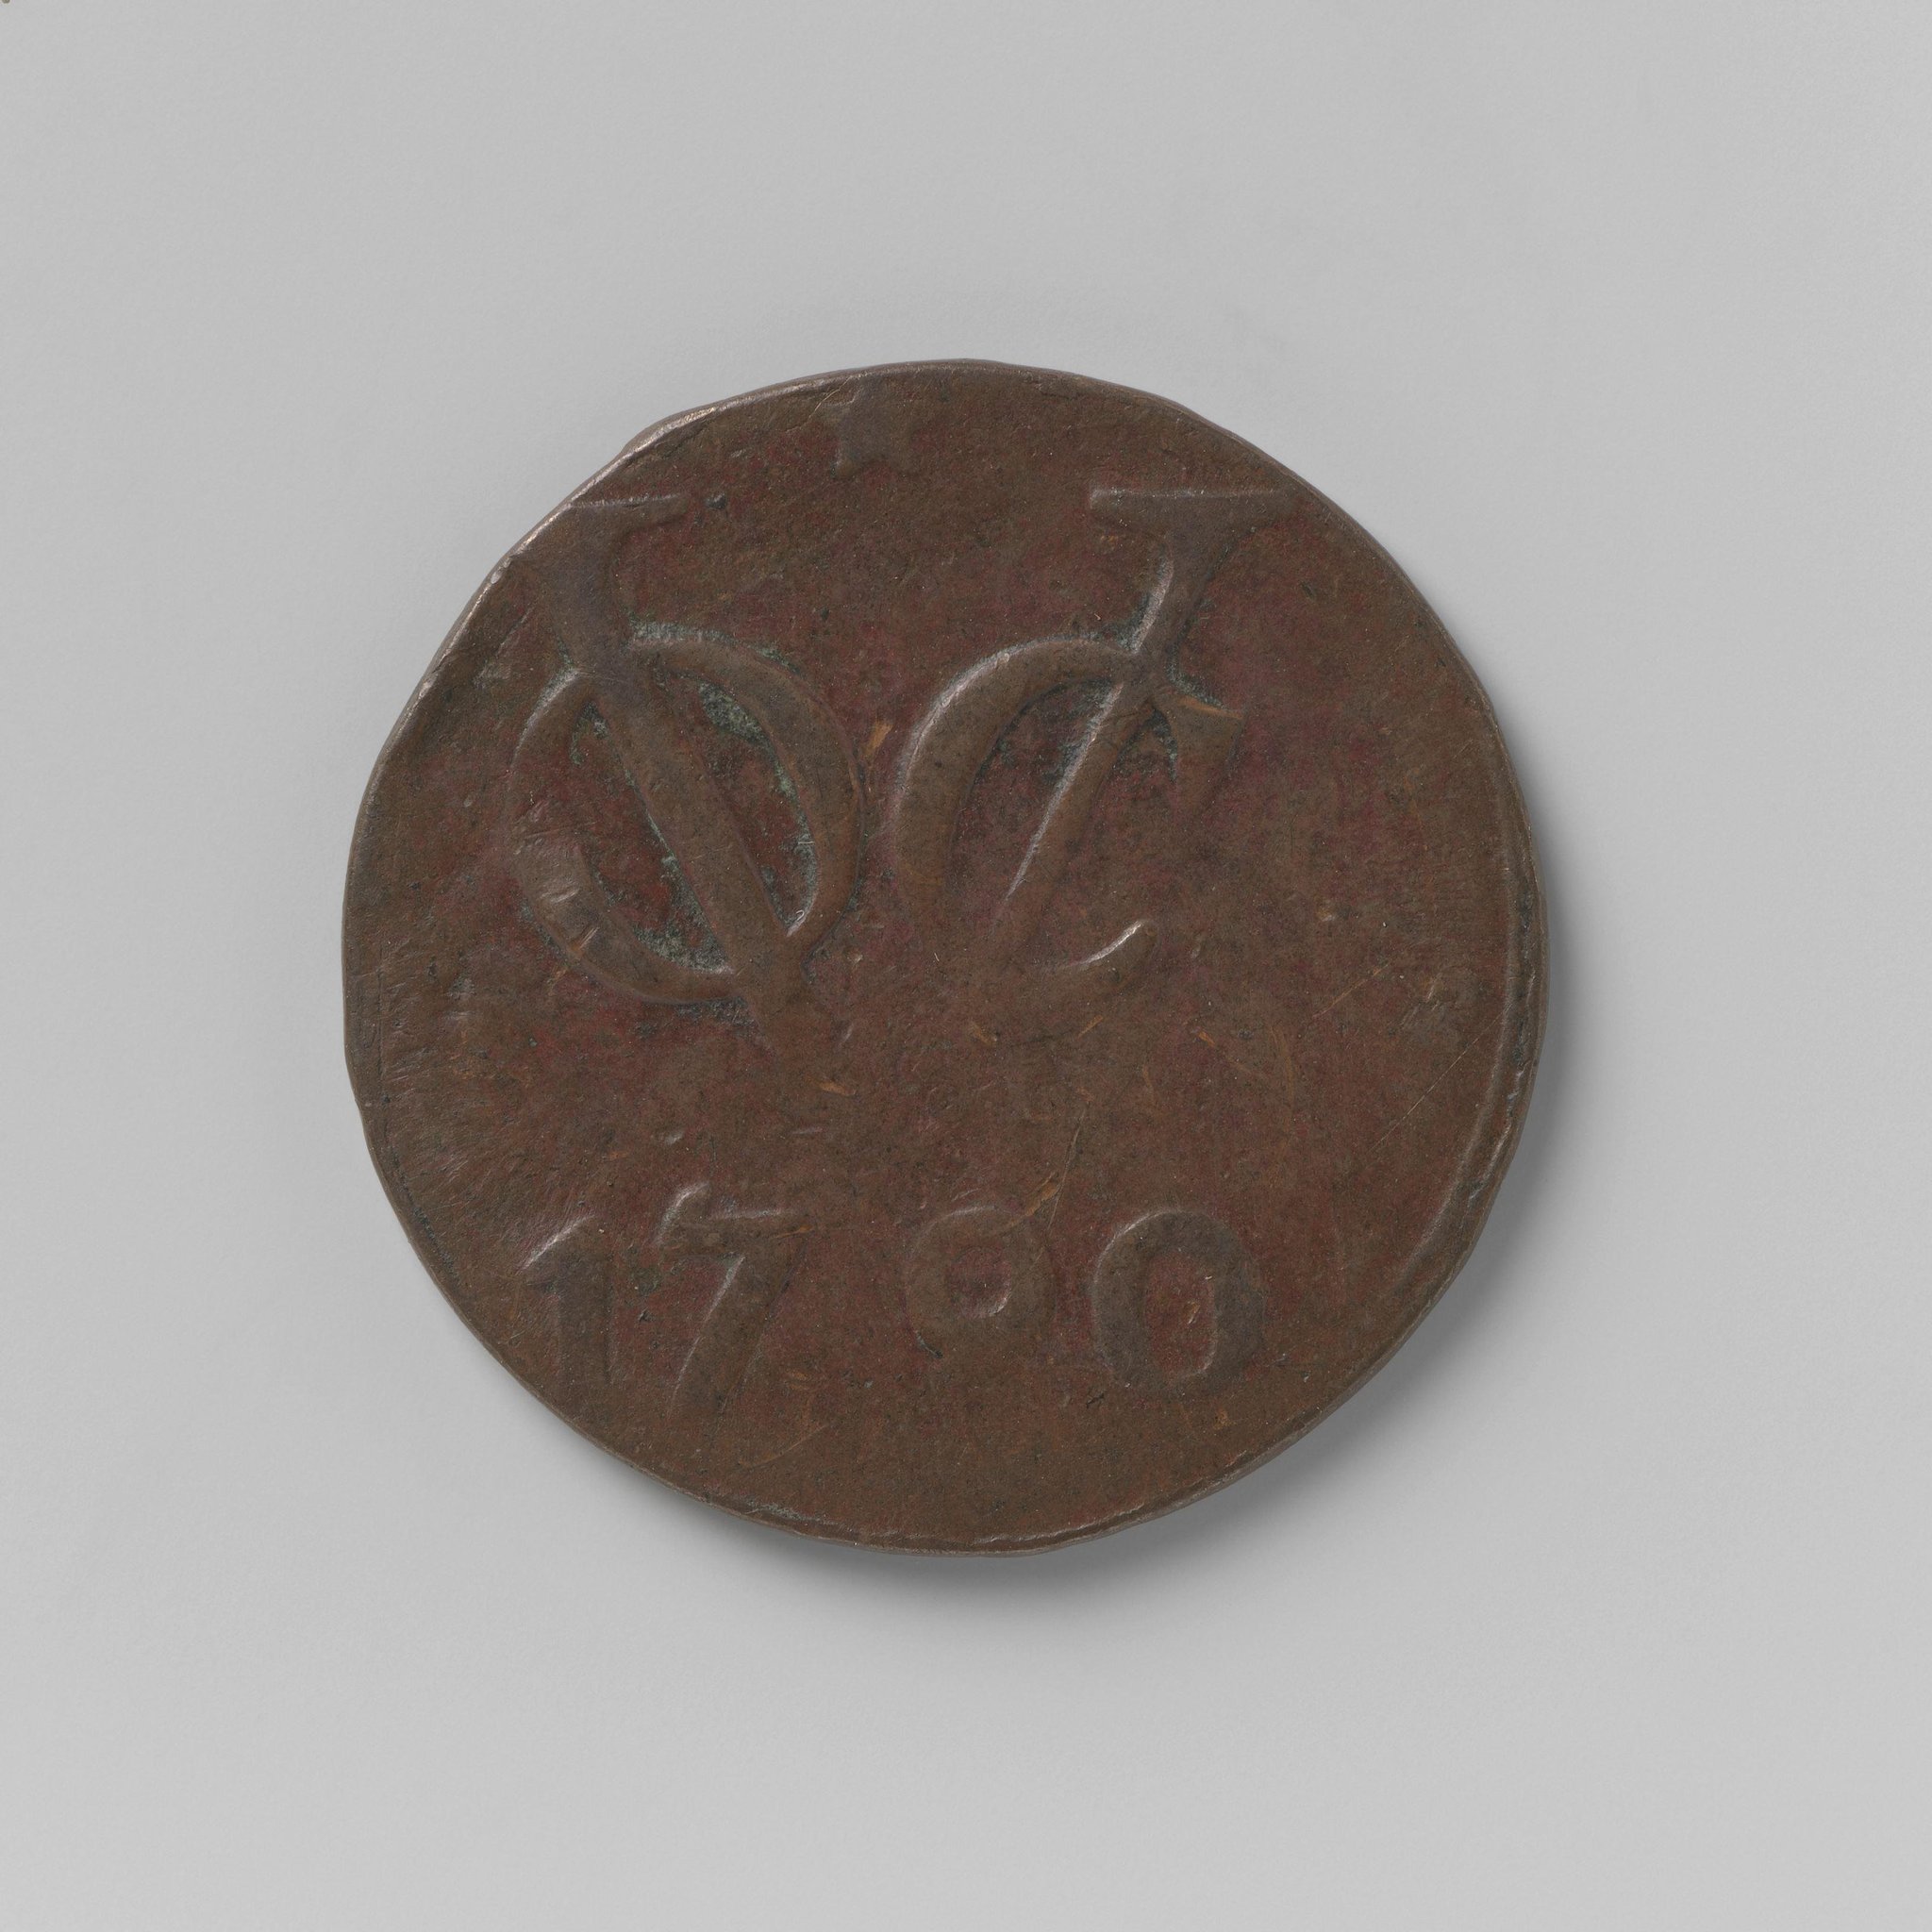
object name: coin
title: VOC, duit op naam van de stad Utrecht met jaartal 1790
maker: william ii of the netherlands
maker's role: koning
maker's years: 1792-1849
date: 1840-1843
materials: copper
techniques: striking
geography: surabaya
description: Koperen munt. Voorzijde: op balk, waaronder guirlande, staand, door twee leeuwen gehouden gekroond wapenschild van de stad Utrecht. Keerzijde: monogram van de VOC, waarboven muntteken ster en waaronder fictief jaartal 1790. Gladde rand.